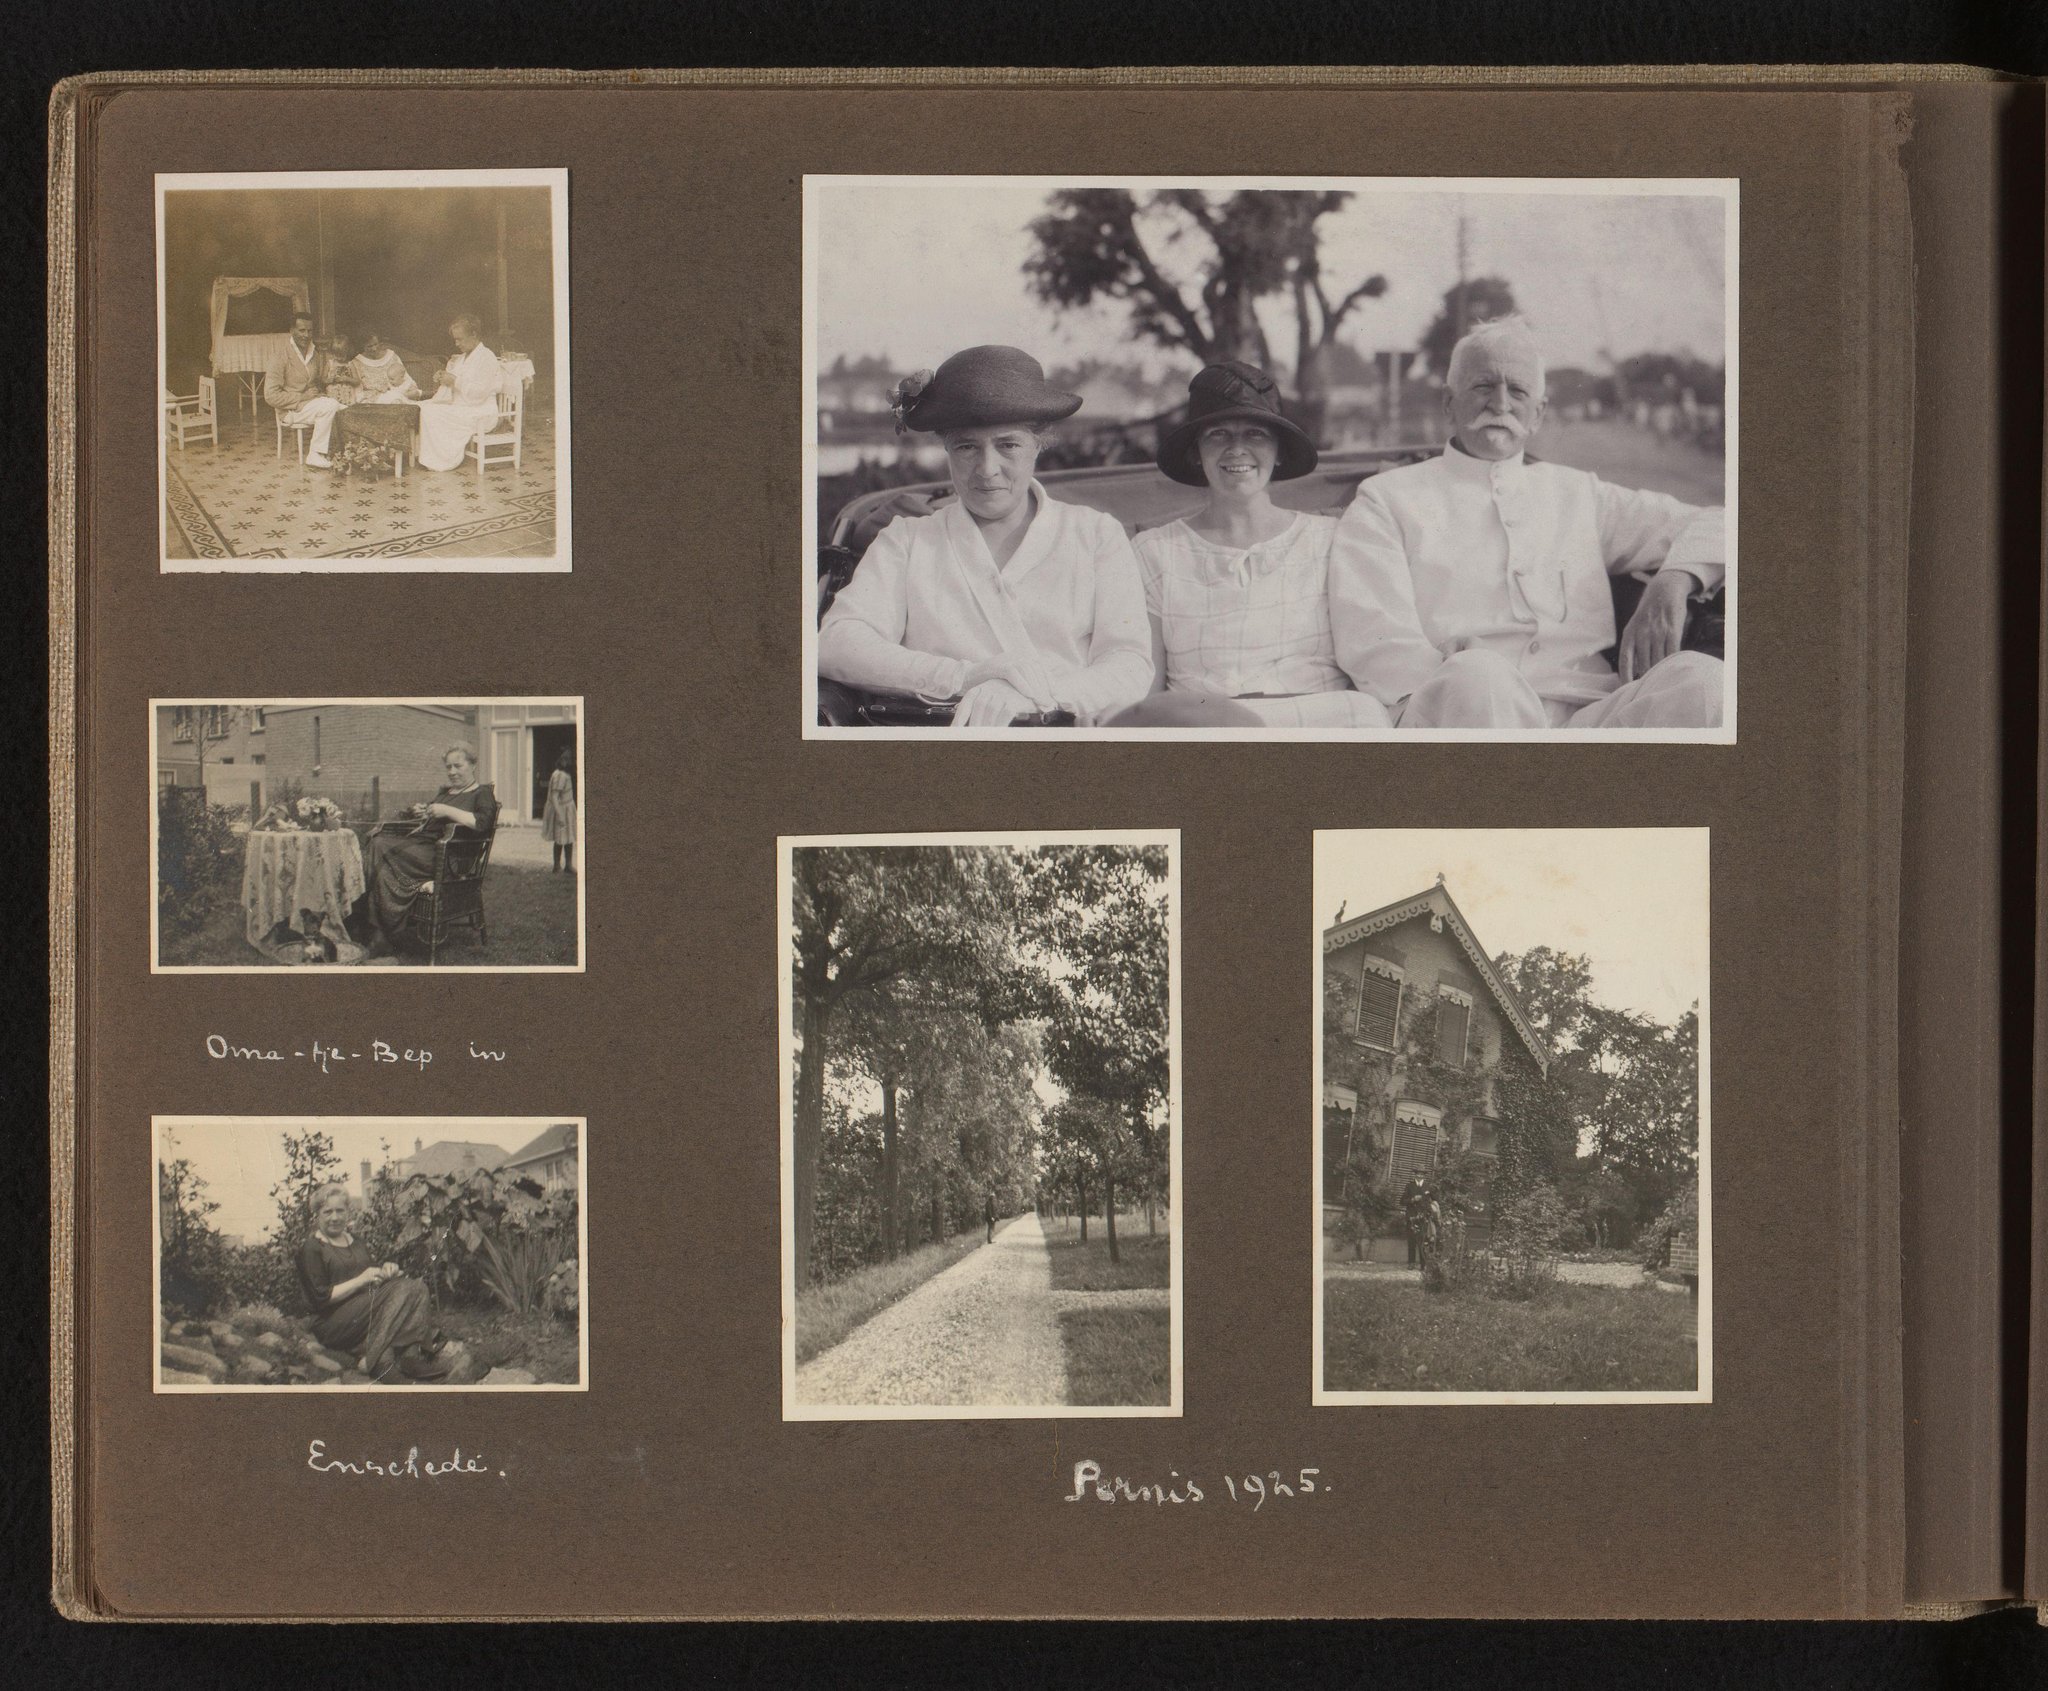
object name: album leaf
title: Familiefoto's in de voormalige kolonie Nederlands-Indië, Enschede en Pernis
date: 1925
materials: paper, cardboard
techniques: gelatin silver print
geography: netherlands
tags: haarlem, elisabeth de jong-van tonderen, garden, terrace, passenger carriage, dutch east indies, the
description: De twee bovenste foto's zijn gemaakt in de voormalige kolonie Nederlands-Indië, met links op de rechter foto Elisabeth de Jong-van Tonderen, de stiefmoeder van Johanna (Hans) de Jong. Deze foto's maken deel uit van een album.